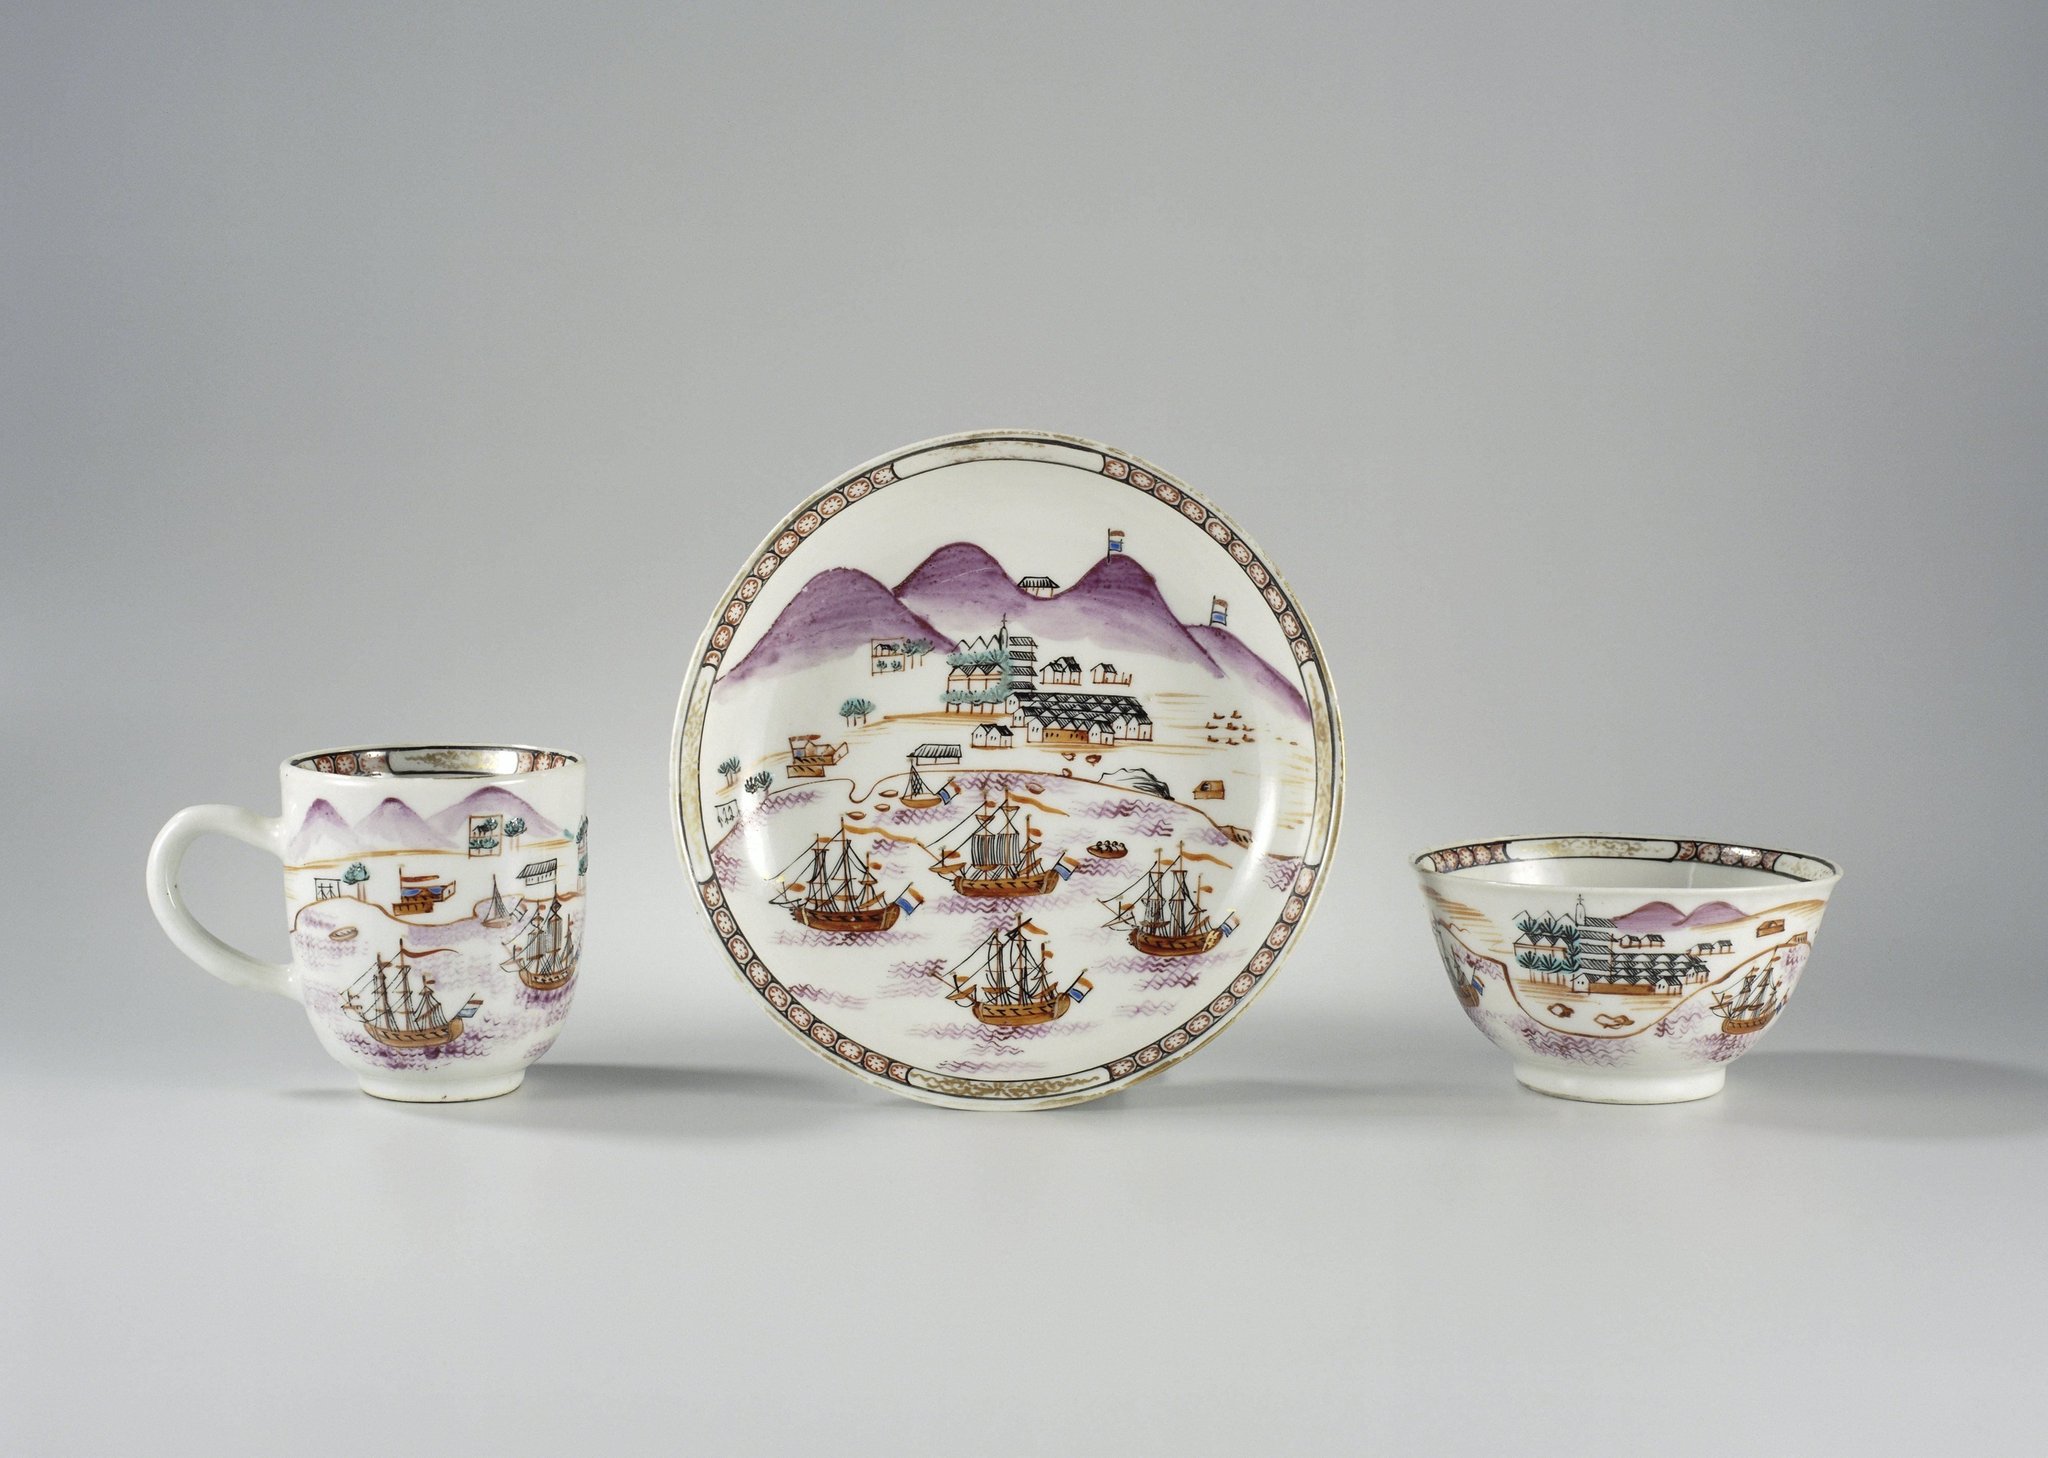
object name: platter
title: Saucer with Dutch ships anchored at the Table Bay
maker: Anonymous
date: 1750-1774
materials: glaze, gold, paint, porcelain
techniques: firing, gilding, turning, vitrification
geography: china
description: Schotel op een voetring. Gedecoreerd in emailkleuren. Op de voorgrond vier schepen met Nederlandse vlag, op de achtergrond de Tafelberg van Kaap de Goede Hoop in Zuid-Afrika. Op de rand vier grote plukken bloemen, afgewisseld met vier kleinere plukken bloemen. Er zijn vele stukken porselein bekend met ongeveer deze zelfde voorstelling. Toch zijn er onderling verschillen: soms worden er vier, dan weer vijf grotere schepen weergegeven. Soms worden de schepen niet in een kring, maar ‘boven elkaar’ afgebeeld. De voorstelling krijgt dan een meer schematisch karakter. Zeereizen, vreemde oorden, schepen, forten en zeeslagen, al deze onderwerpen zijn terug te vinden op porselein. Plaatsen en gebeurtenissen langs de route van de VOC naar de Oost hadden uiteraard de belangstelling op de zeelui uit de 17de en 18de eeuw en zij zijn veelvuldig op porselein weergegeven.